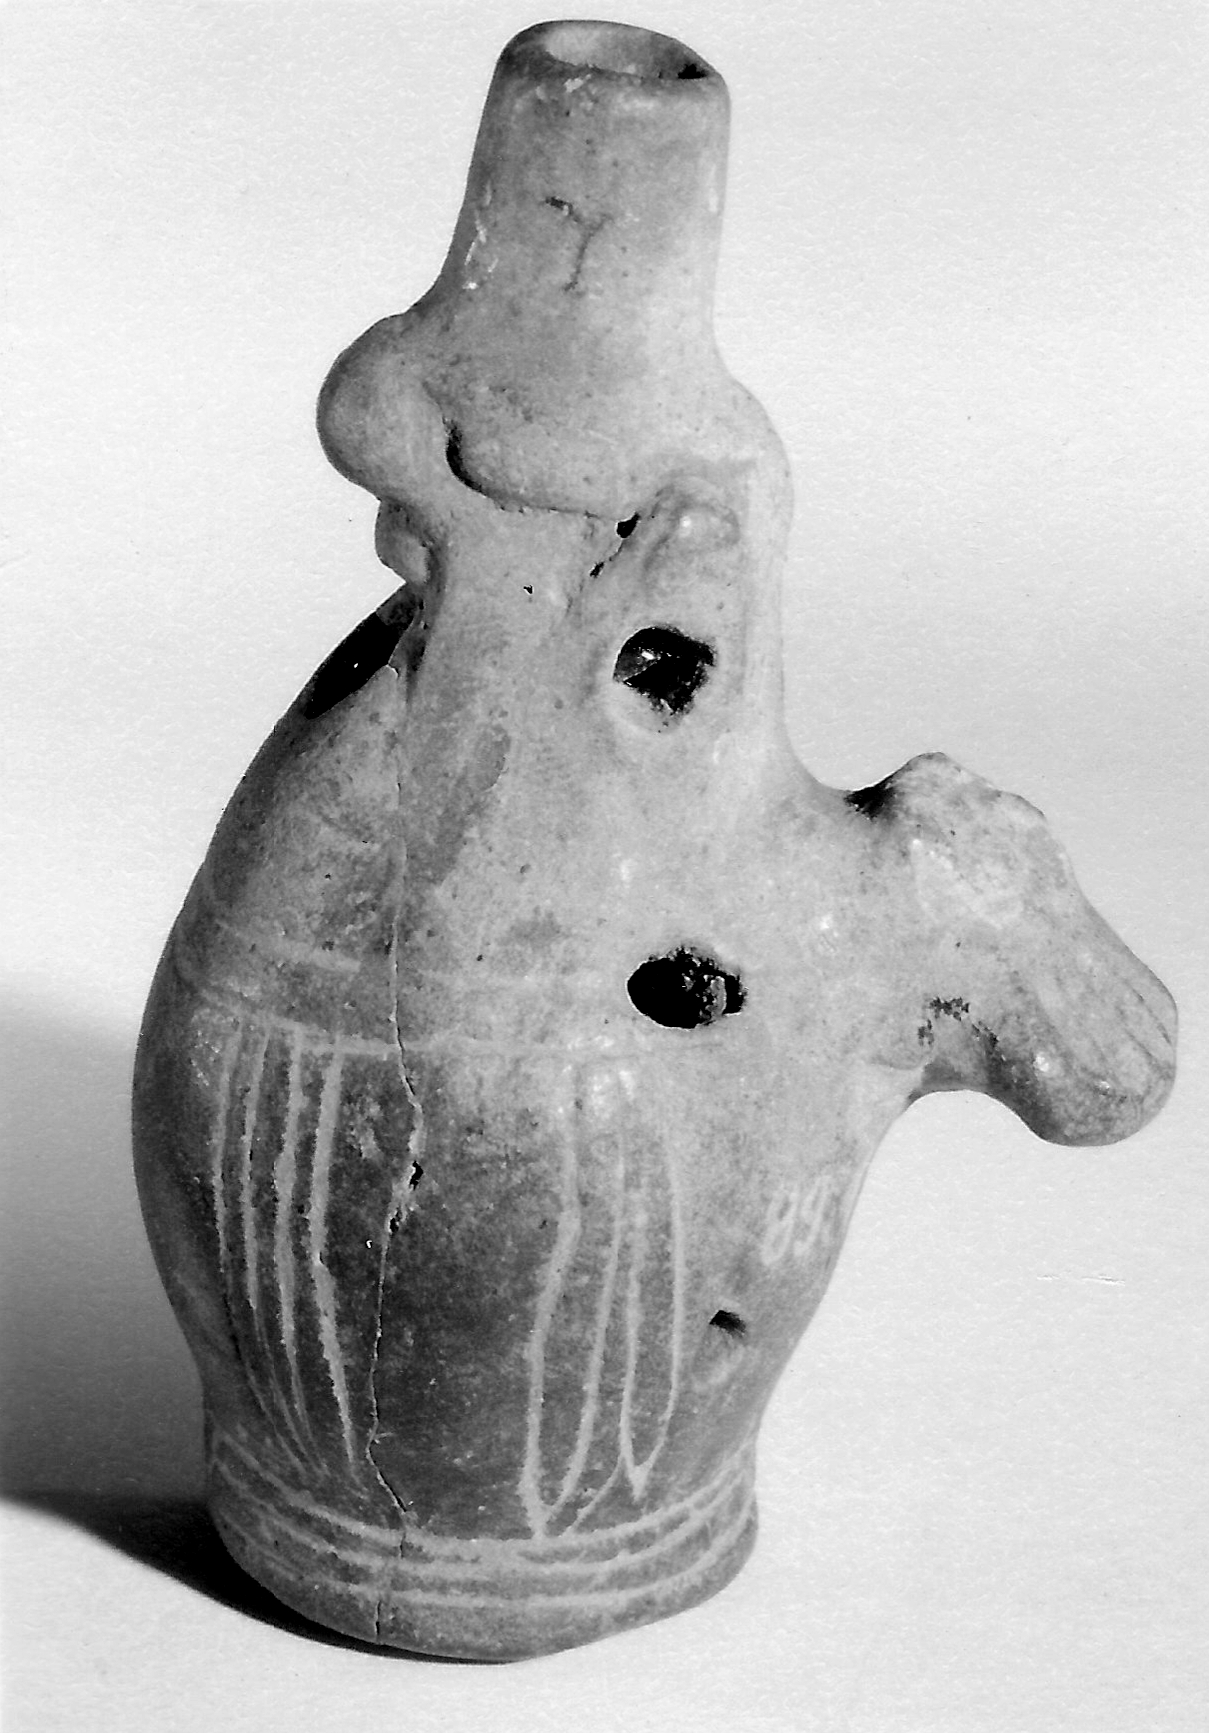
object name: pottery whistle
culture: costa rican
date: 800-1500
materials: clay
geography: costa rica